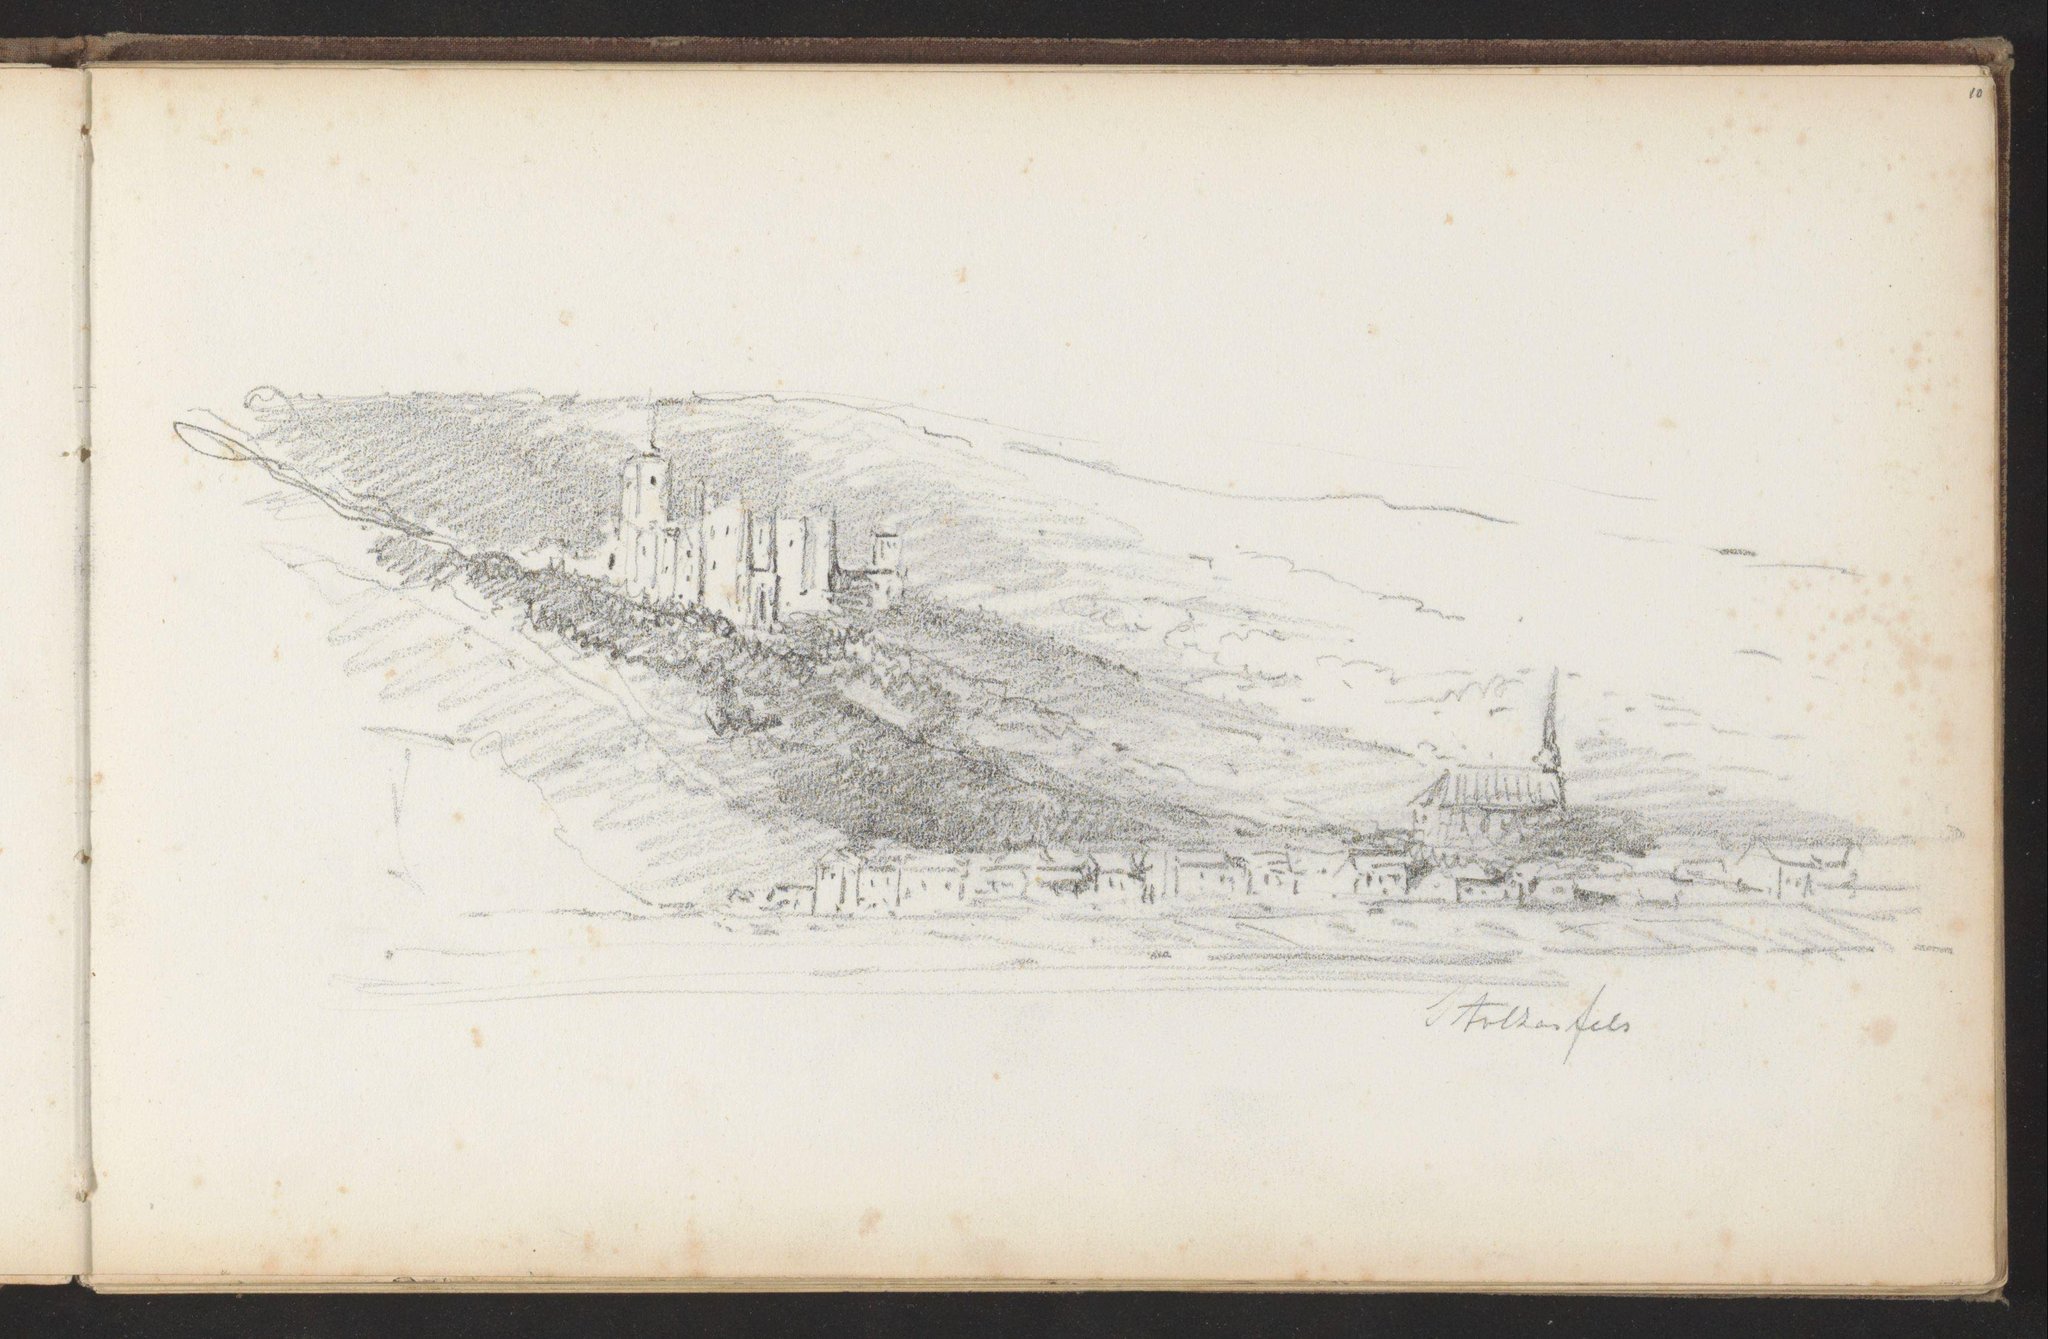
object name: sketchbook leaf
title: Slot Stolzenfels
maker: maria vos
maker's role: draughtsman, painter, print maker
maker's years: 1824-1906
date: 1860-1865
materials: paper, pencil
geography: koblenz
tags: landscape with tower or castle, mountains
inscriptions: annotation: ‘Stolzenfels’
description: Blad 10 recto uit een schetsboek met 55 bladen.